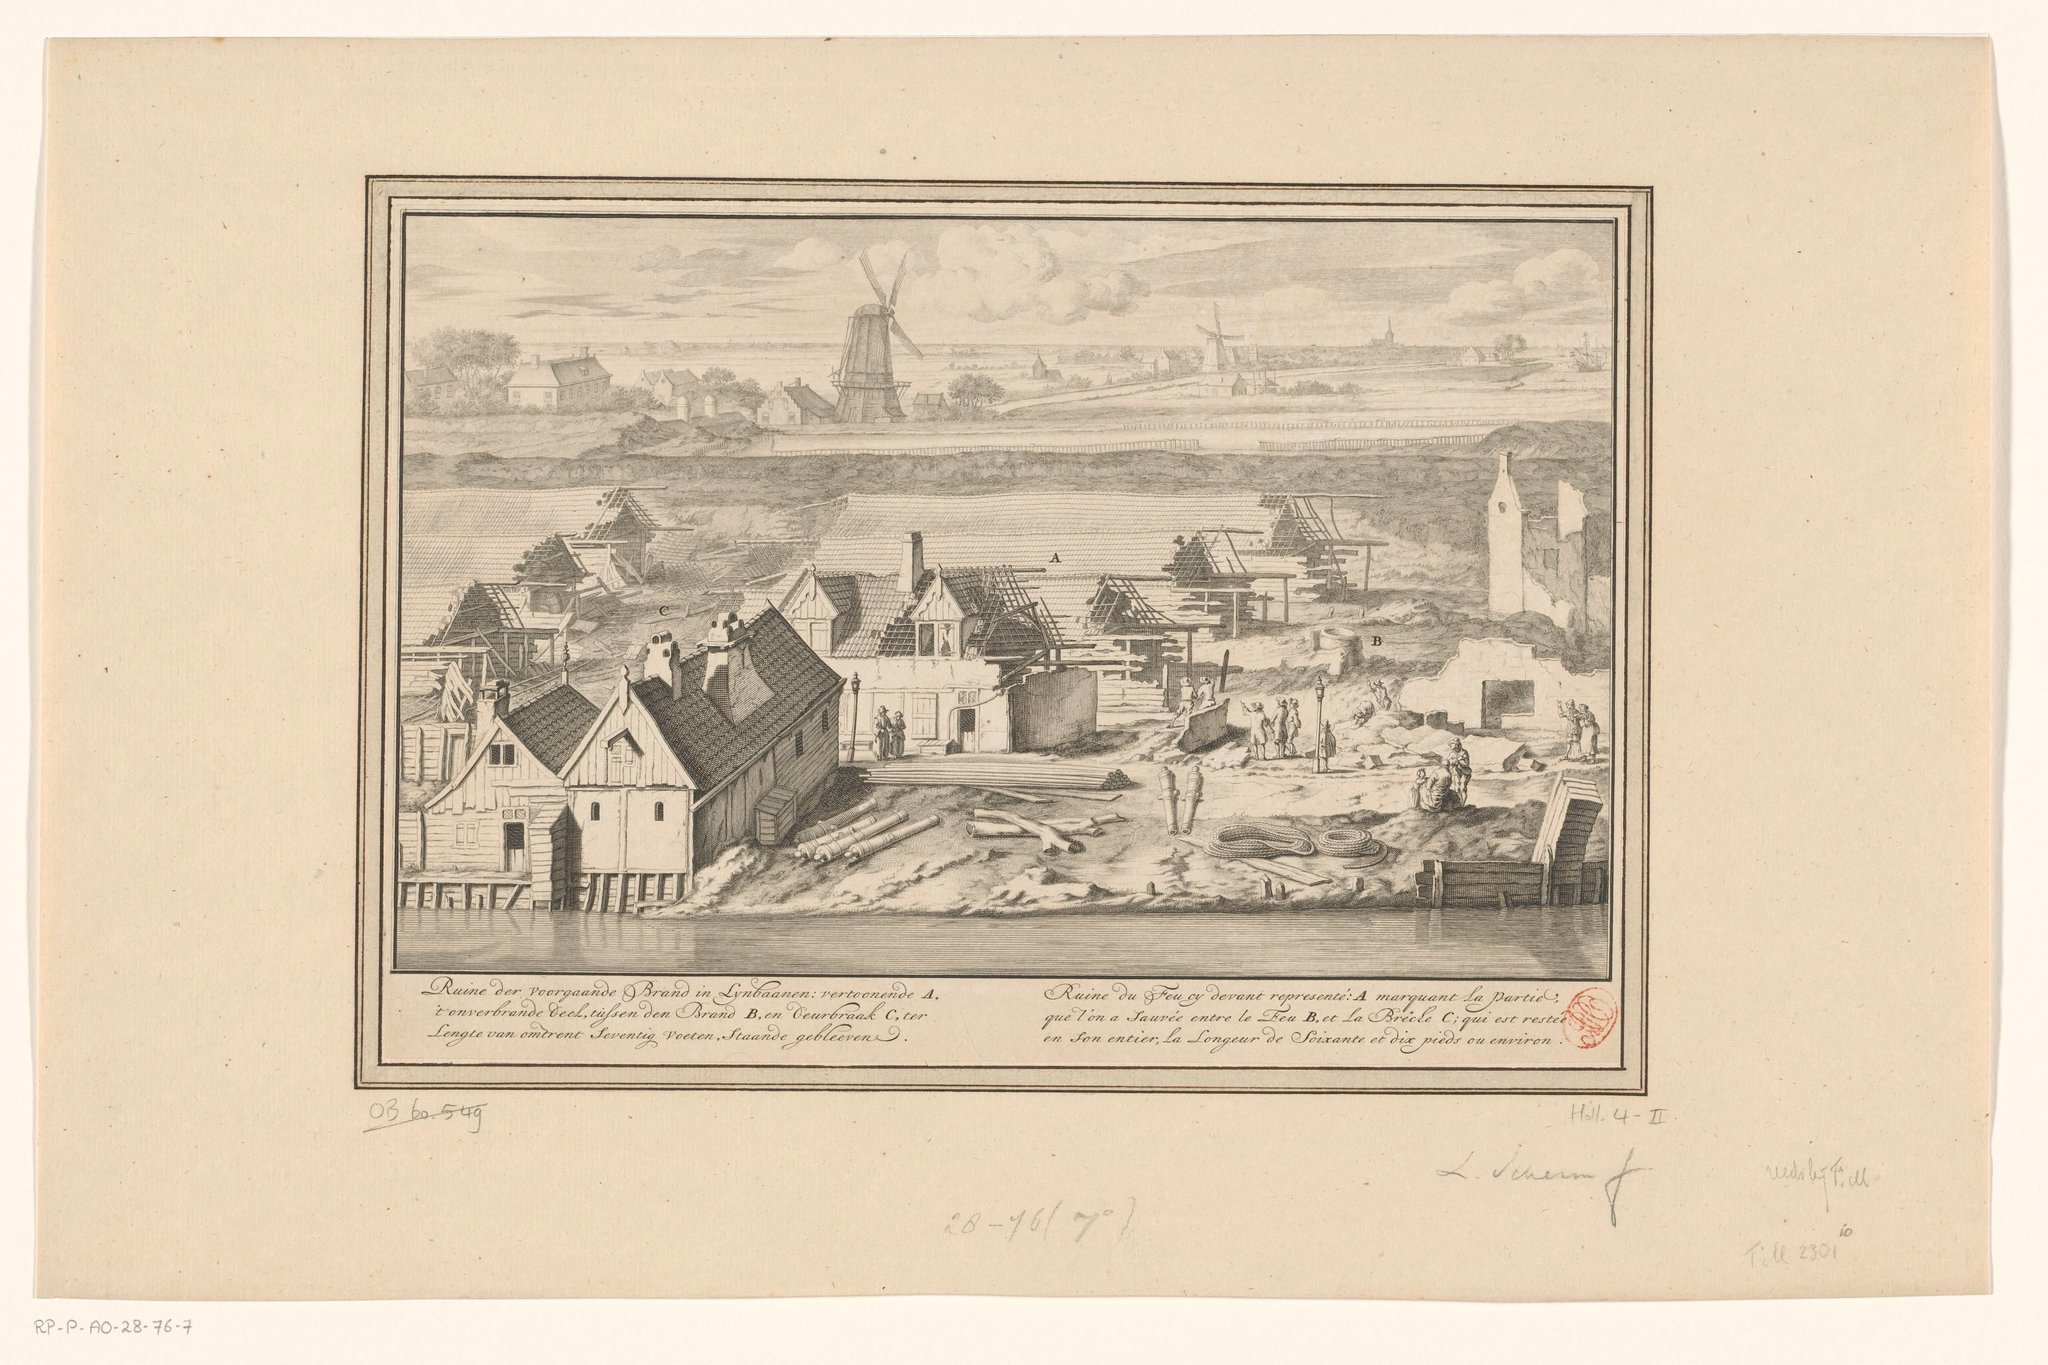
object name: book illustration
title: Ruine der voorgaande brand in lynbaanen (…) / Ruine du feu cy devant representé (…)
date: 1690-1735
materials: paper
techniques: engraving, etching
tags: amsterdam, painter, print maker, draughtsman, jan van der heyden, ruin of a building ~ architecture, landscape with ruins, ropery, rope-walk, fire-extinguishing equipment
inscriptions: collector's mark: Lugt 2228, collector's mark: Lugt 195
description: Prent ook gebruikt in: Heyden, Jan van der. Beschryving der nieuwlyks uitgevonden en geoctrojeerde slang-brand-spuiten en haare wyze van brand-blussen, tegenwoordig binnen Amsterdam in gebruik zijnde (…). 1e druk. Amsterdam: Jan Rieuwertsz. (II), 1690. En in: Heyden, Jan van der. Beschryving der nieuwlyks uitgevonden en geoctrojeerde slang-brand-spuiten en haare wyze van brand-blussen, tegenwoordig binnen Amsterdam in gebruik zijnde (…). 2e druk. Amsterdam: erfgenamen Jan van der Heyden, 1735. Voor ontwerptekening zie RP-T-00-158. Voor eerdere staat (voor de letter) zie RP-P-1944-236.